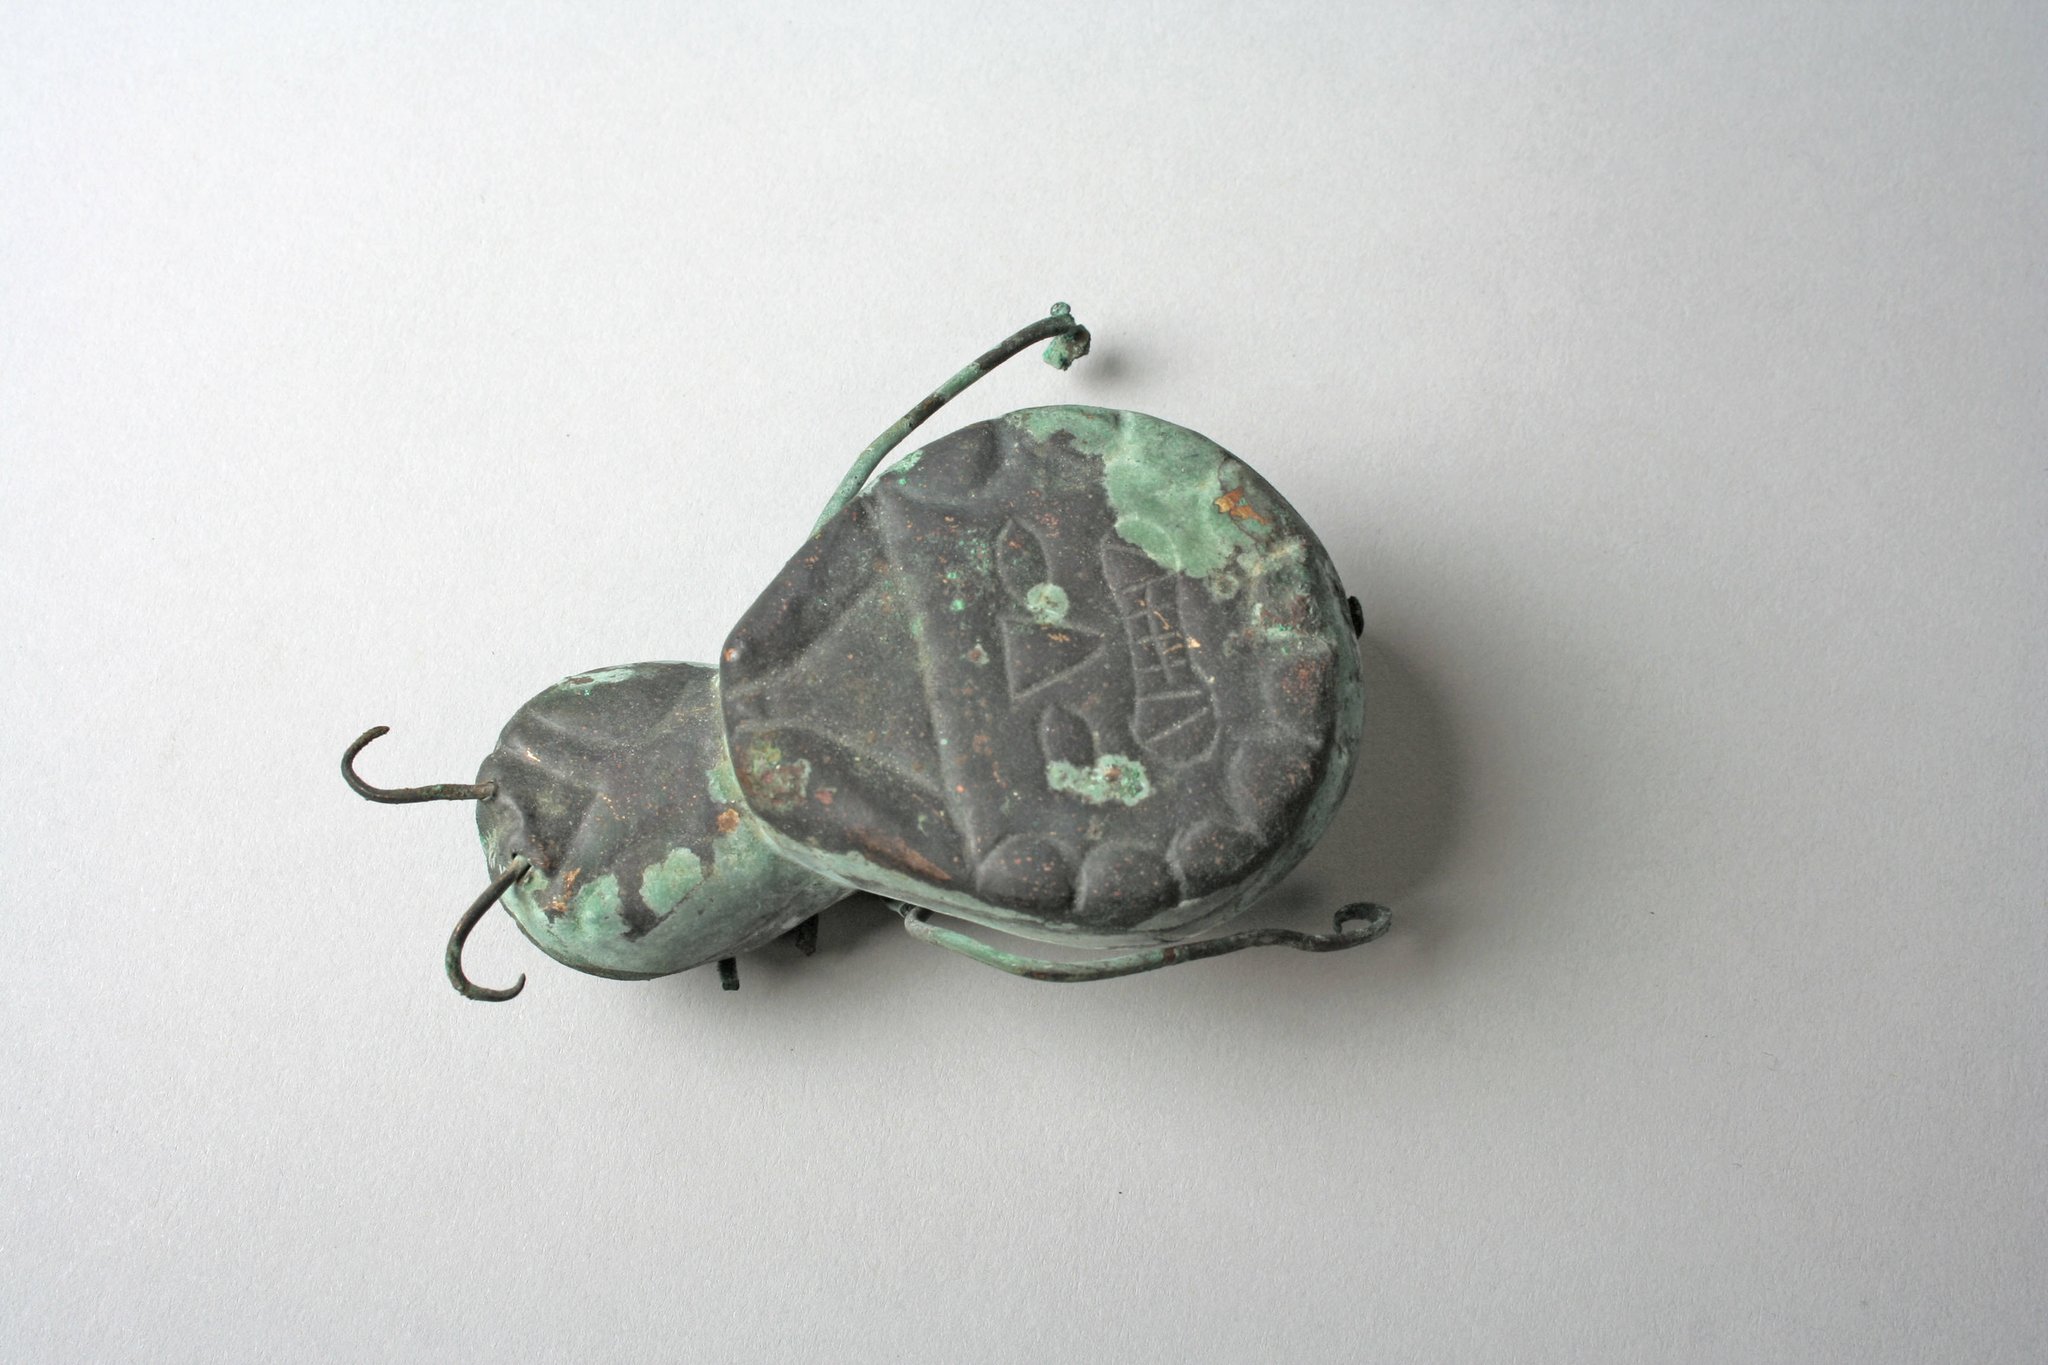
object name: ornament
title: Spider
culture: moche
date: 501-700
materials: gilt copper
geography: peru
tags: insects